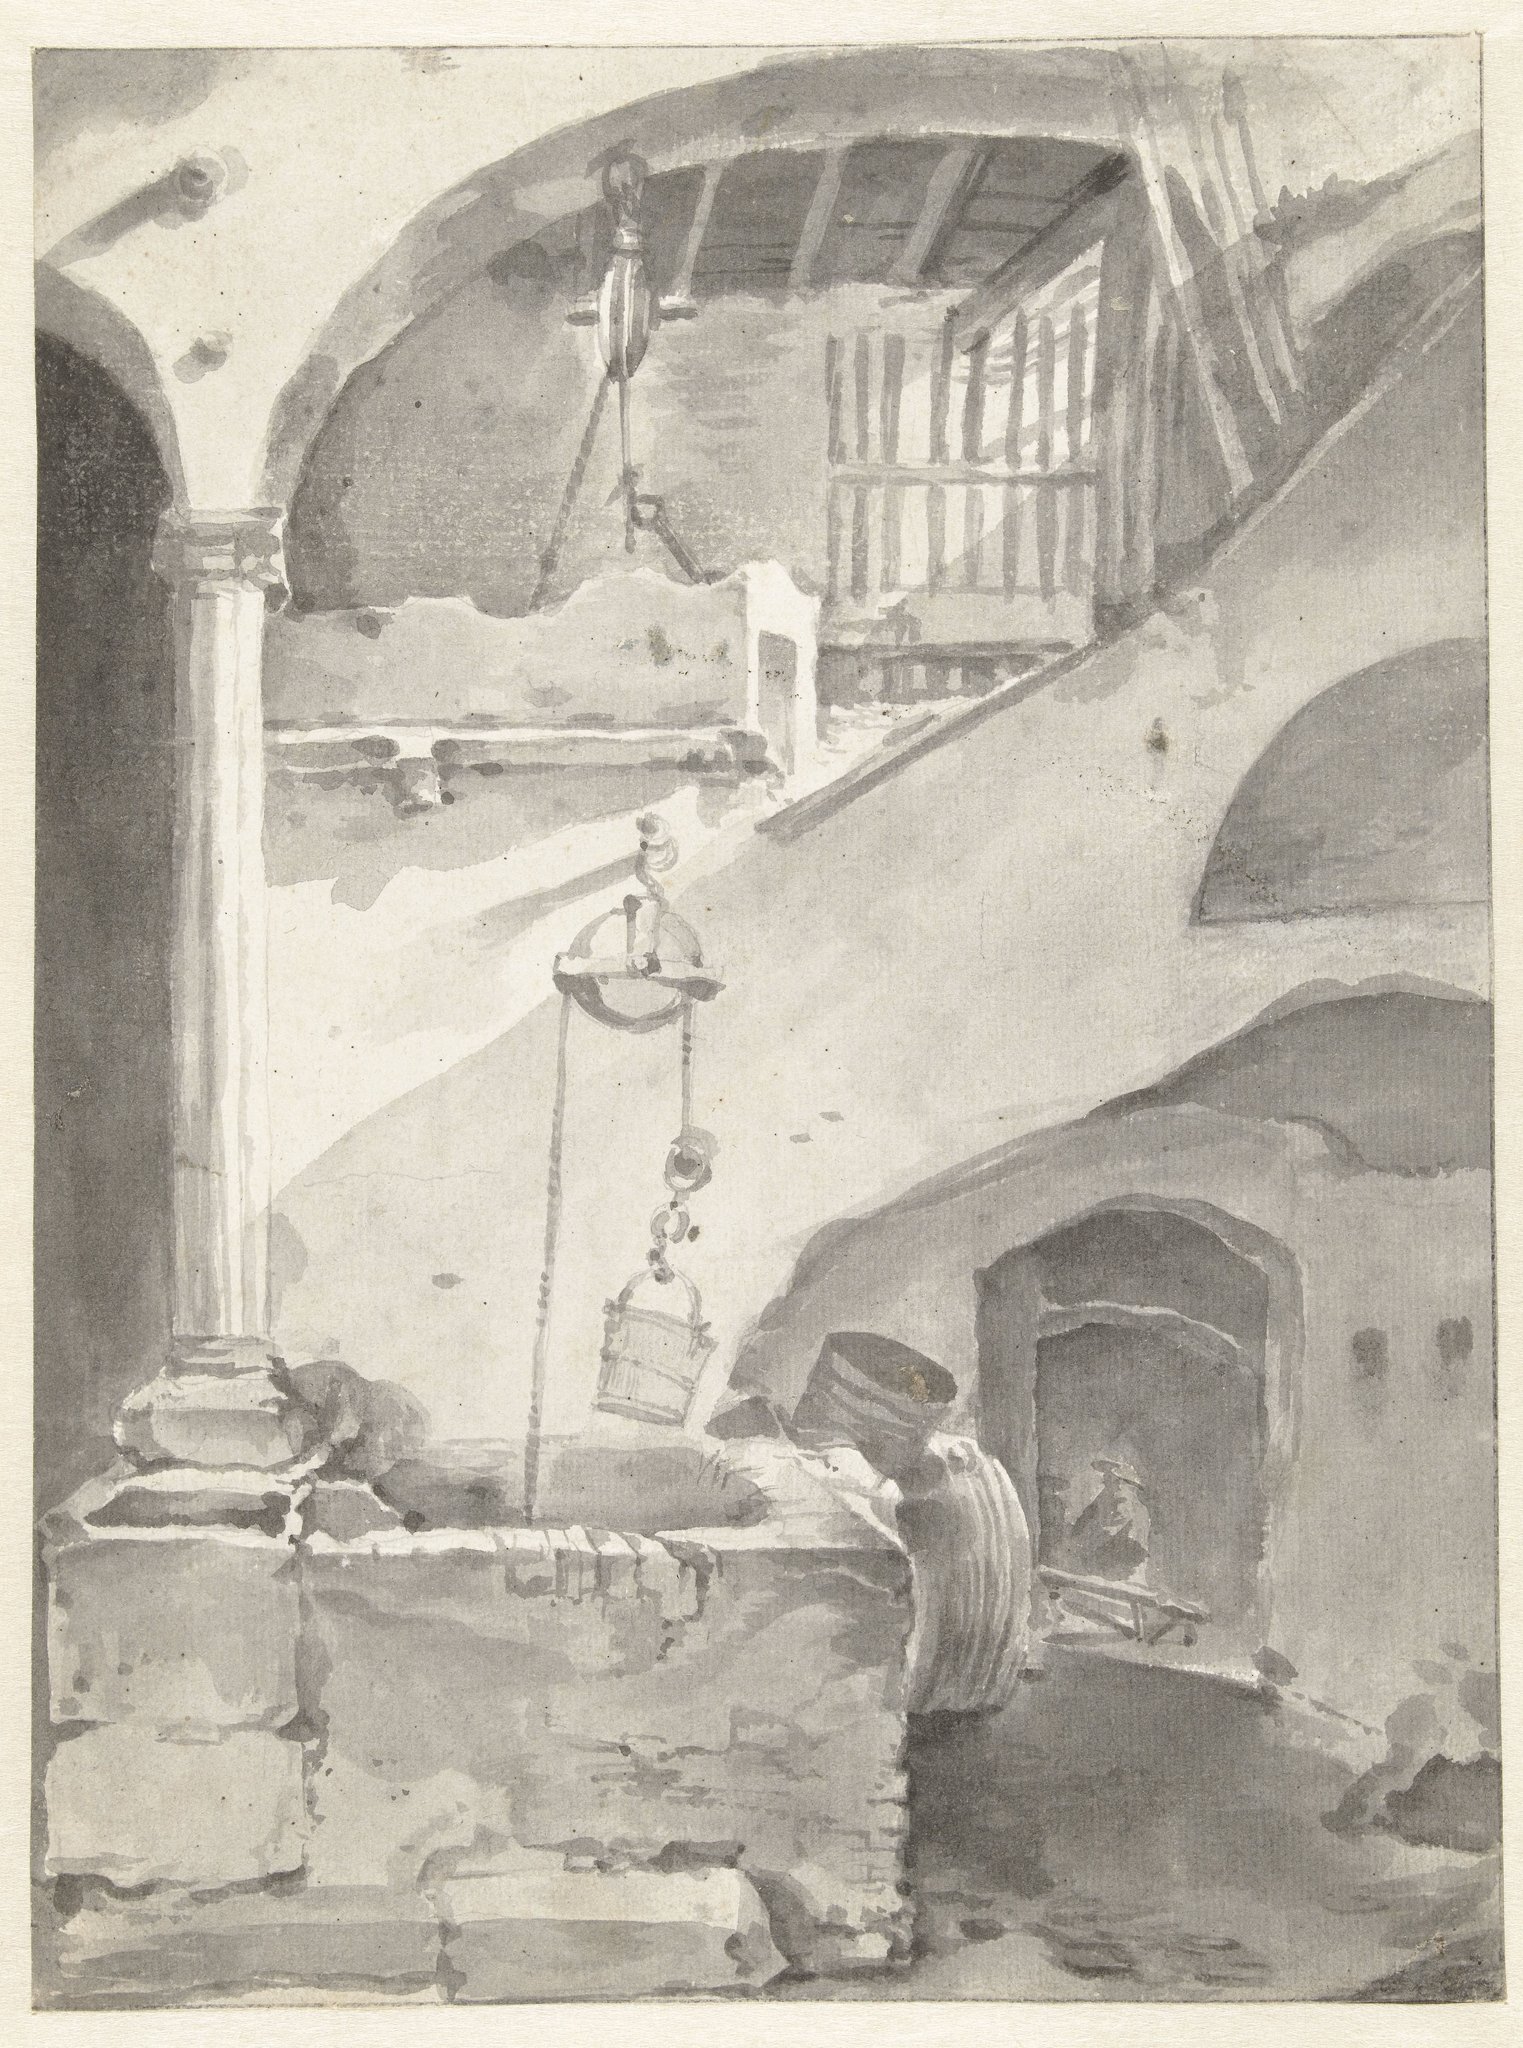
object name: drawing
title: Italiaanse binnenplaats met een waterput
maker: thomas wijck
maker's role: draughtsman, painter, print maker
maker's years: 1616-1677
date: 1626-1677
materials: paper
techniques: brush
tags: well, courtyard, italy